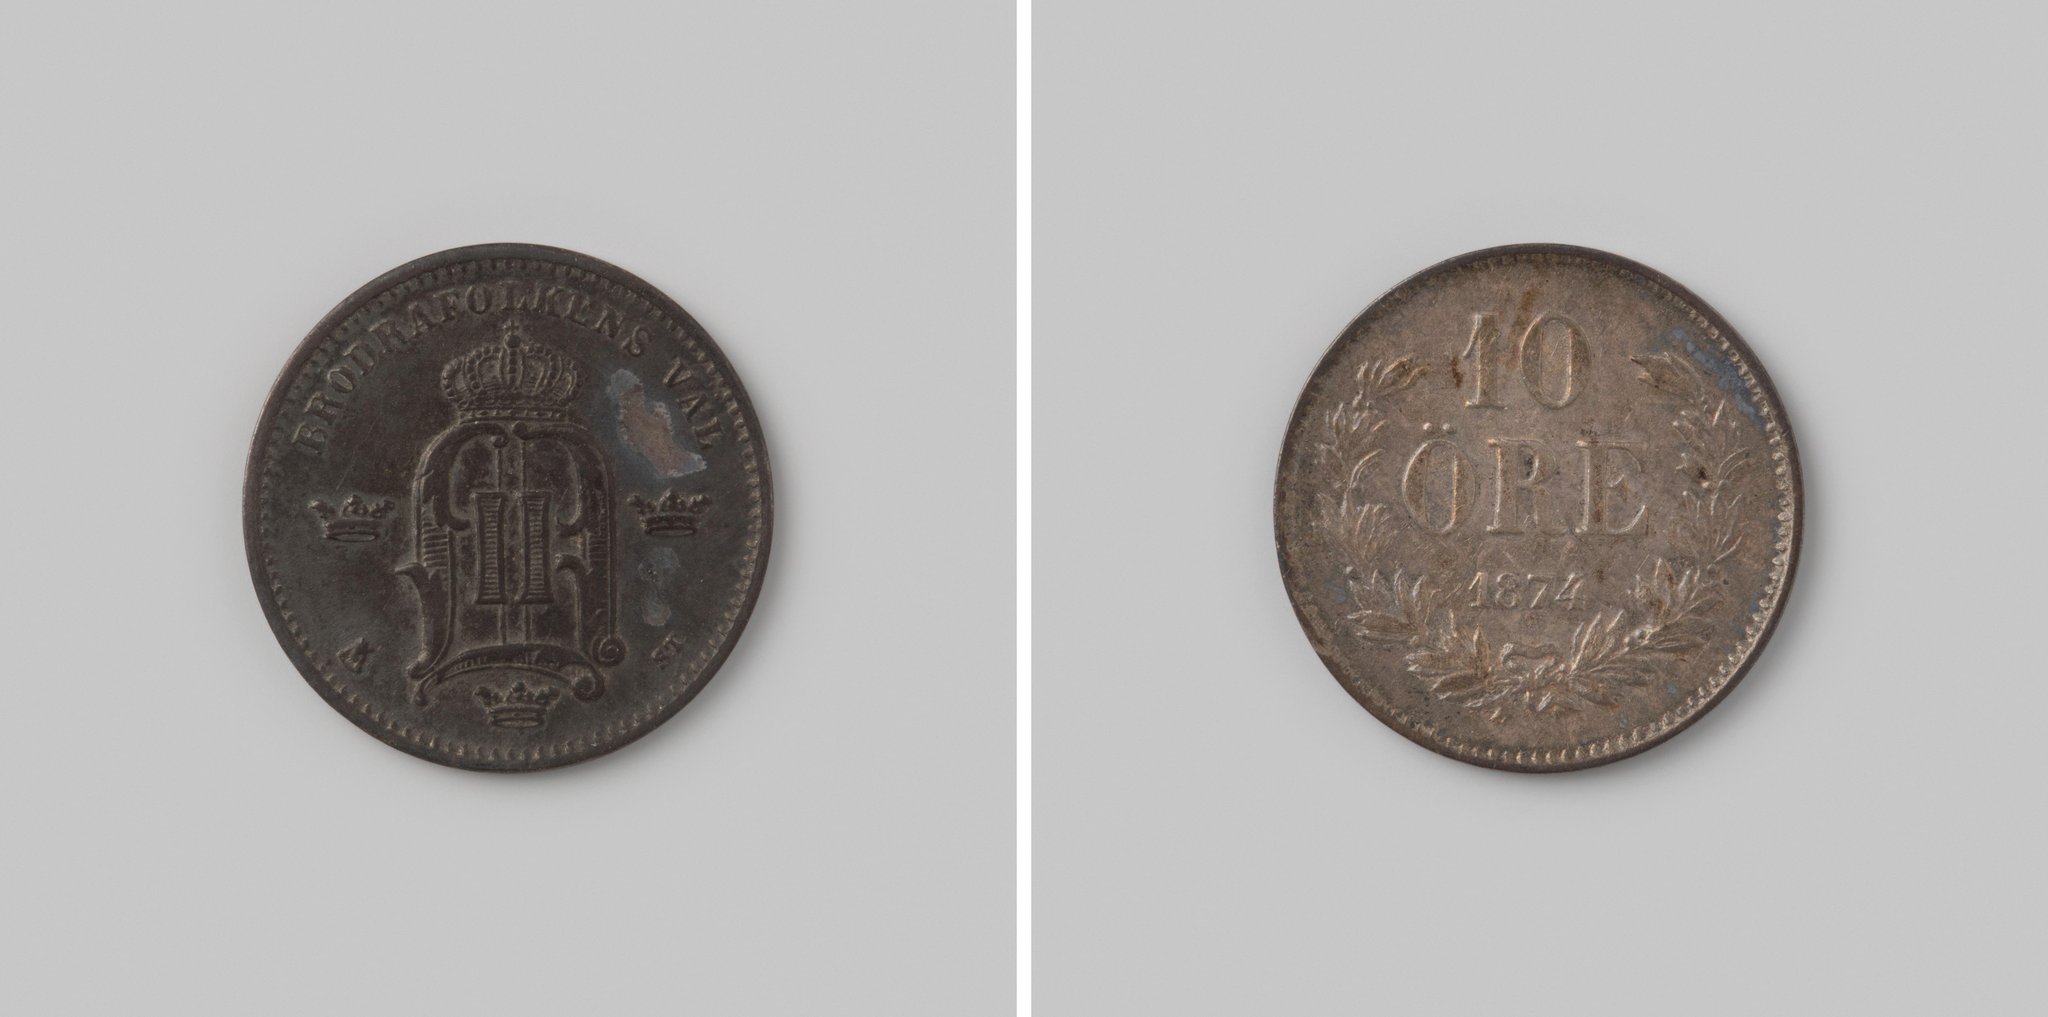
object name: coin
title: 10 öre uit Zweden van Oskar II, 1874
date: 1874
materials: silver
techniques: striking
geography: slot rörstrand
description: Zilveren munt. Voorzijde: tussen drie kronen monogram van de koning, waarboven koningskroon. Keerzijde: binnen twee samengebonden takken waarde-aanduiding in twee regels. Daaronder jaartal. Gladde rand.